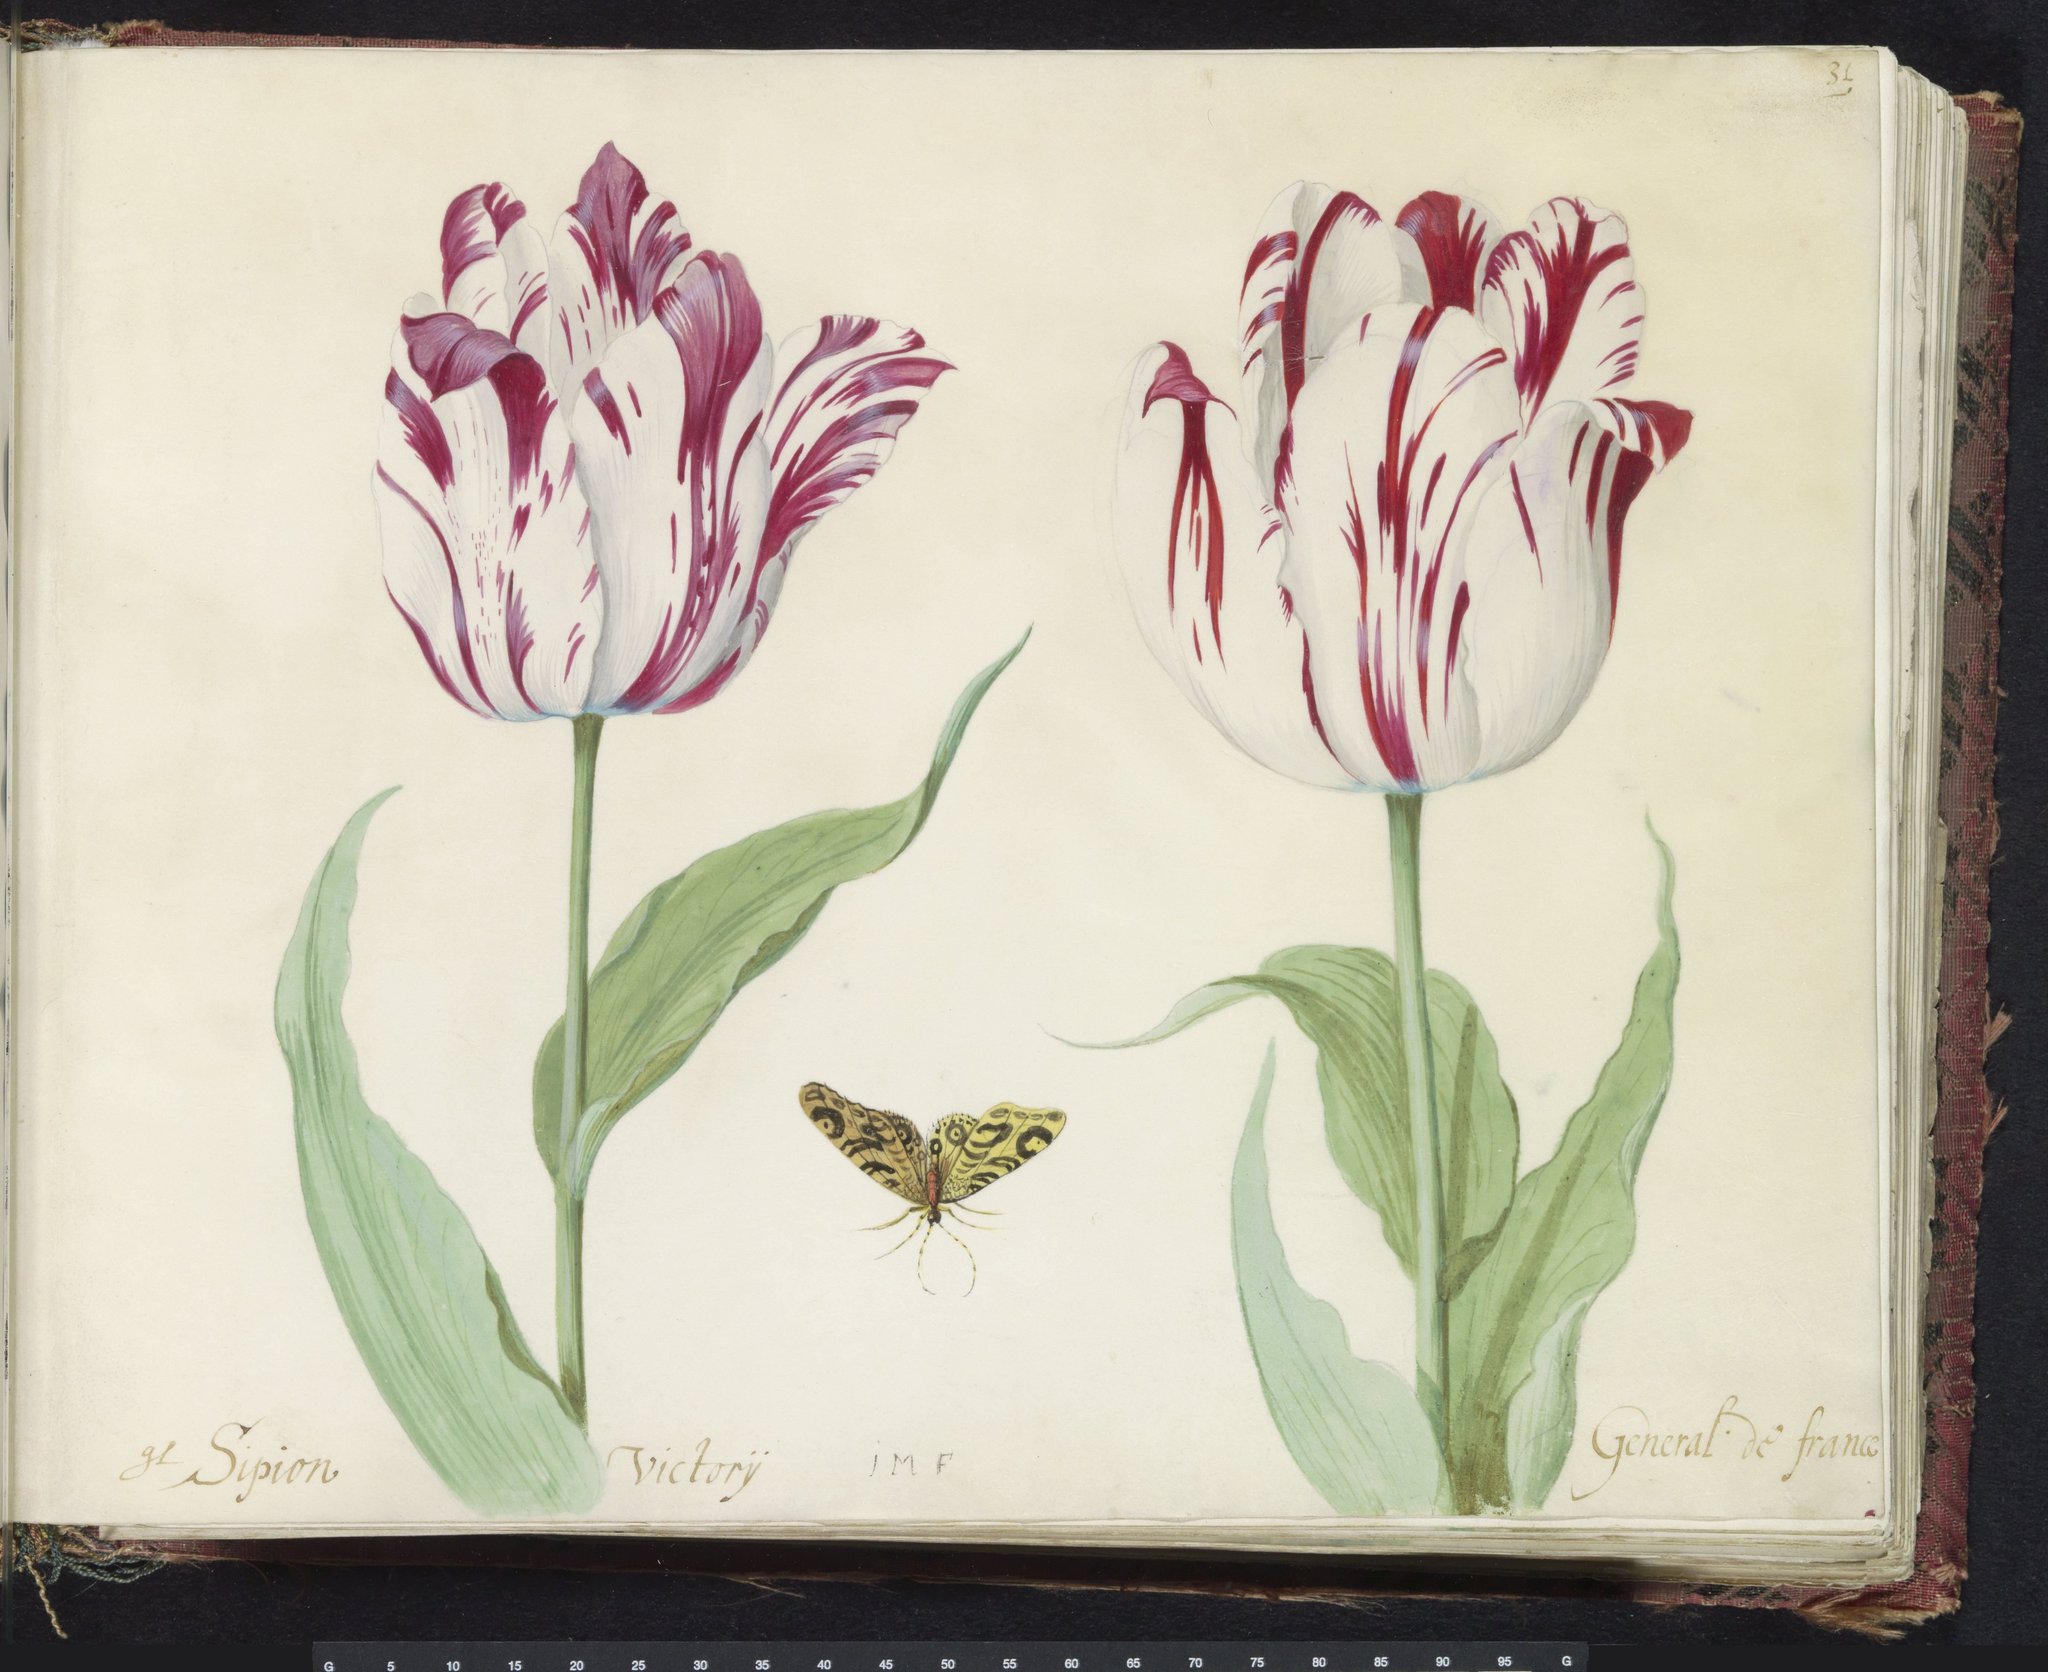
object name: album leaf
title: Twee tulpen met vlinder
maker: jacob marrel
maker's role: draughtsman, painter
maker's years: 1614-1681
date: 1639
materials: paint, parchment, pencil, watercolor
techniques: brush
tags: insects: butterfly, flowers: tulip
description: De tekening maakt deel uit van een album.